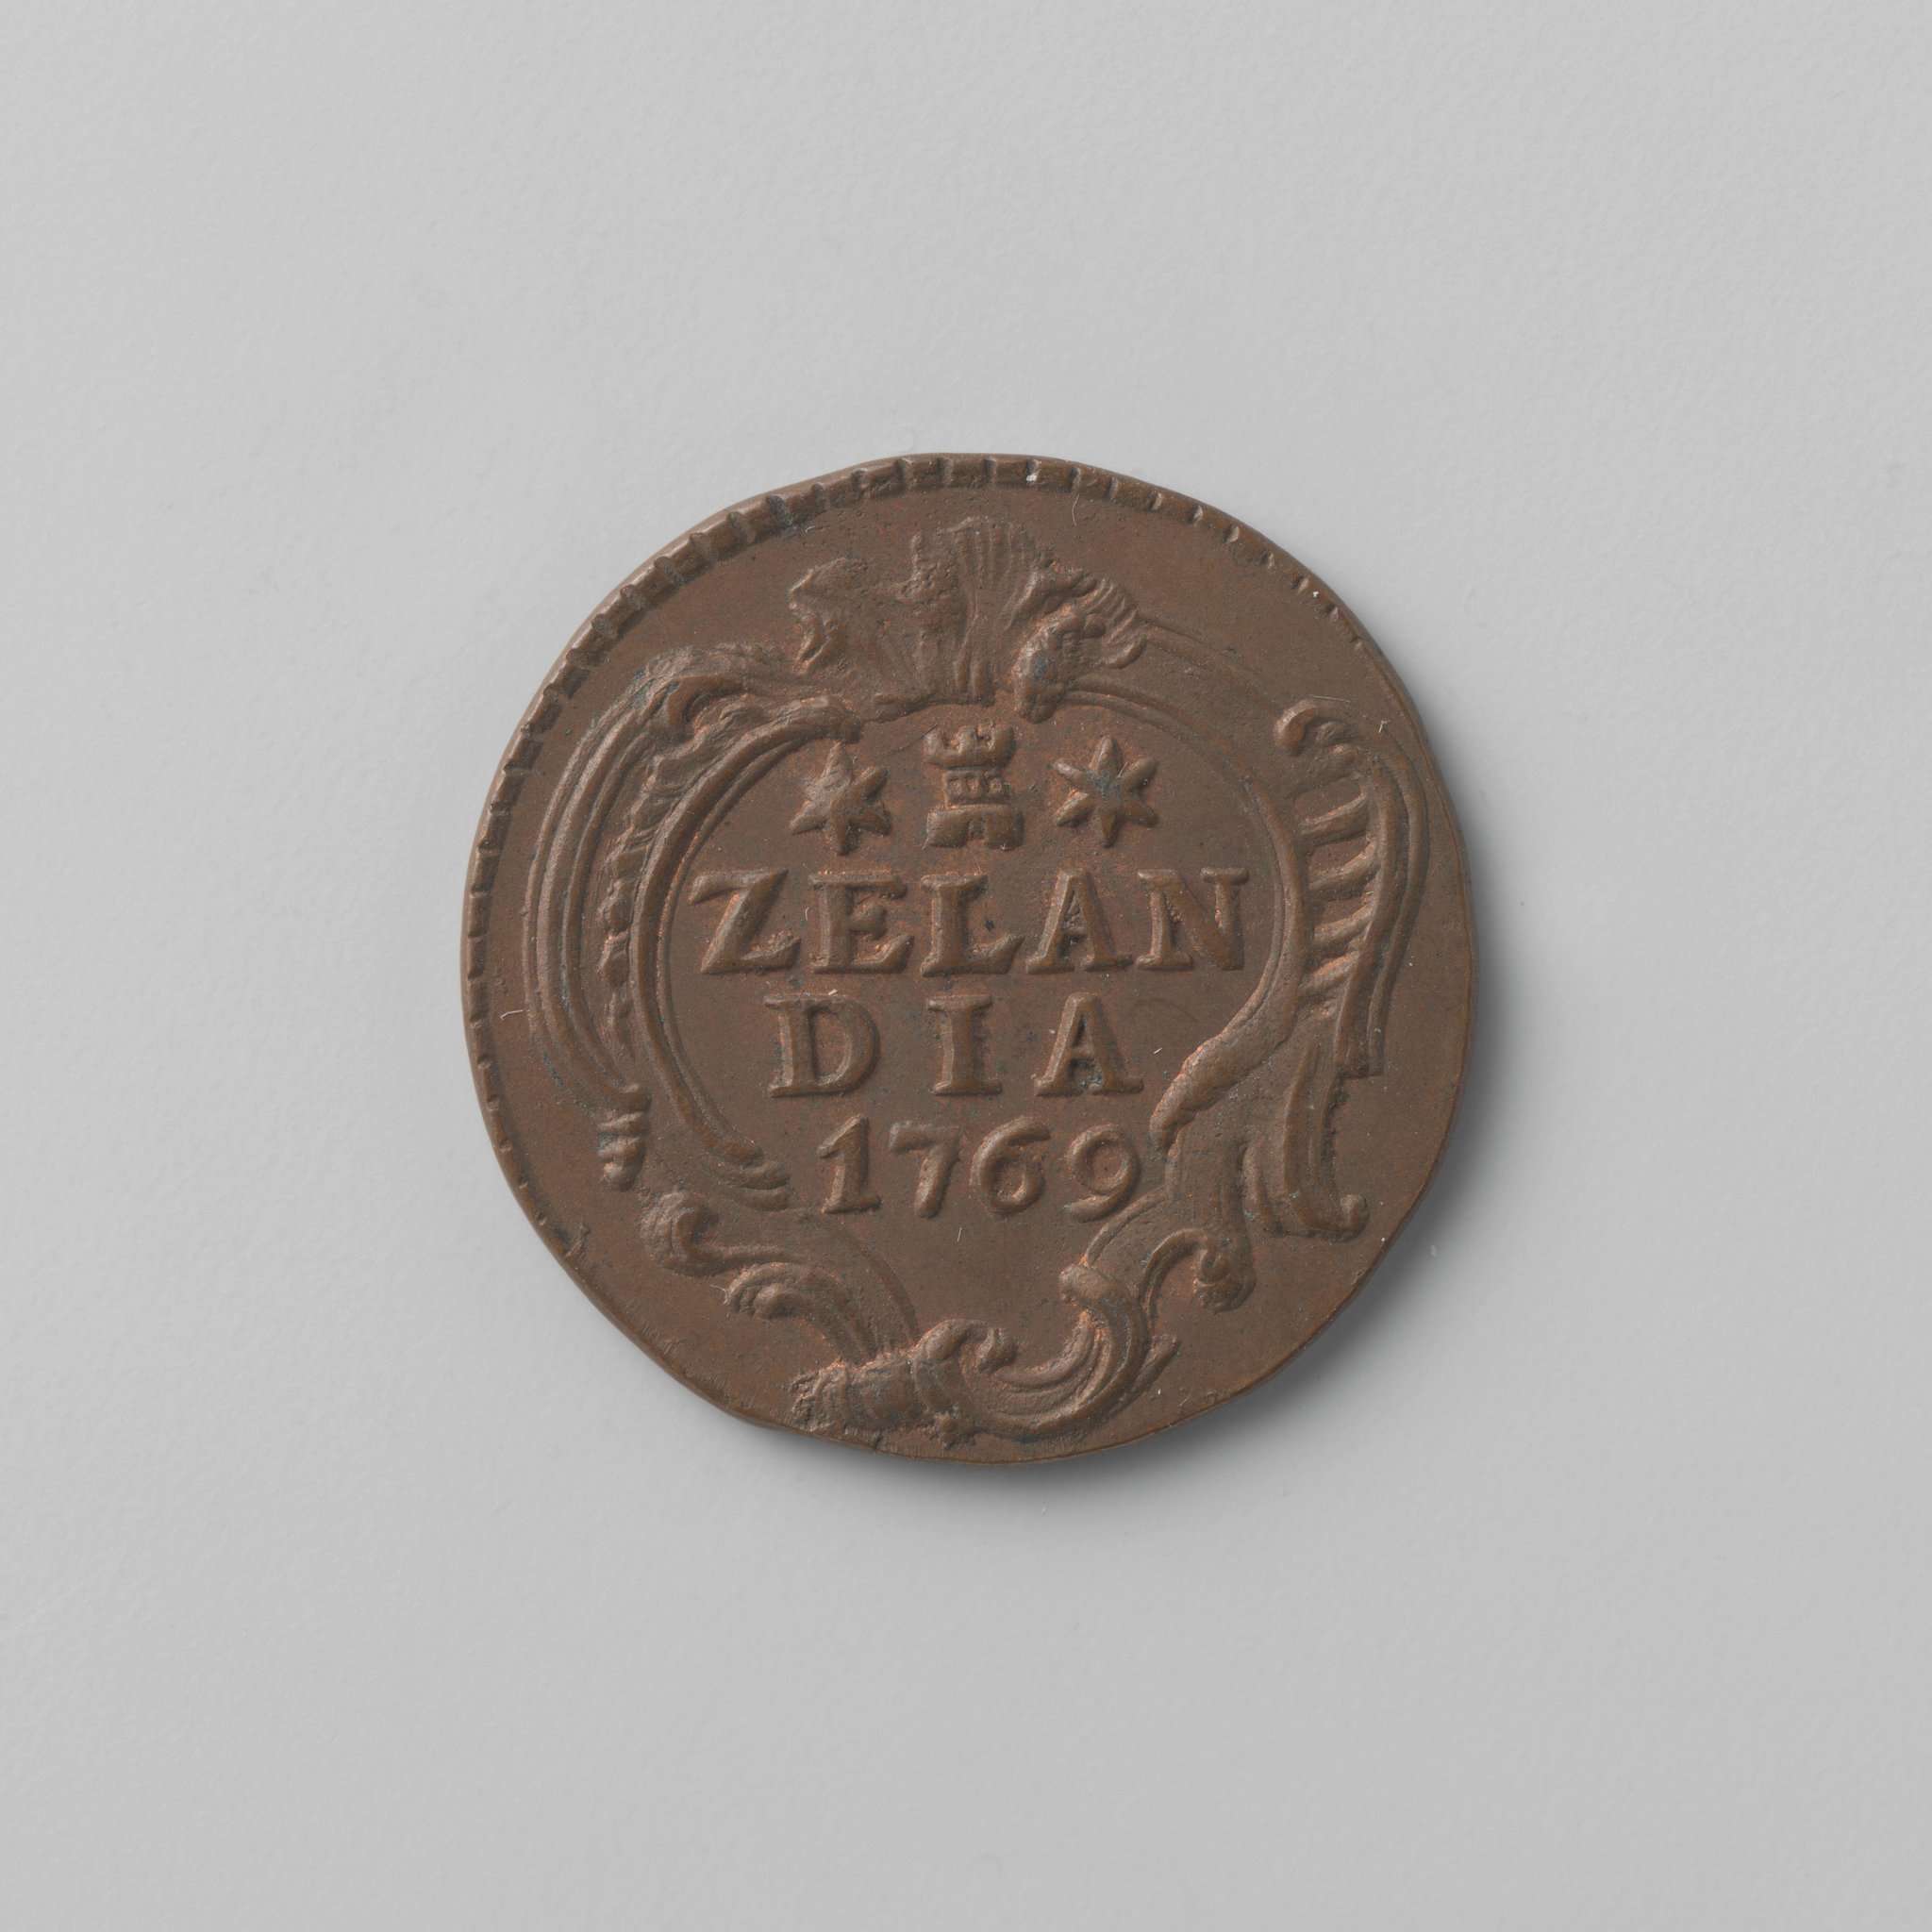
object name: coin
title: Zeeuwse duit, 1769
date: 1769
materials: copper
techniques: striking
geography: middelburg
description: Koperen munt. Voorzijde: in rococo-lijst gekroond ovaal wapenschild van Zeeland. Keerzijde: in een rococo-versiering opschrift in drie regels, waarboven muntteken burcht tussen twee sterren en waaronder jaartal.